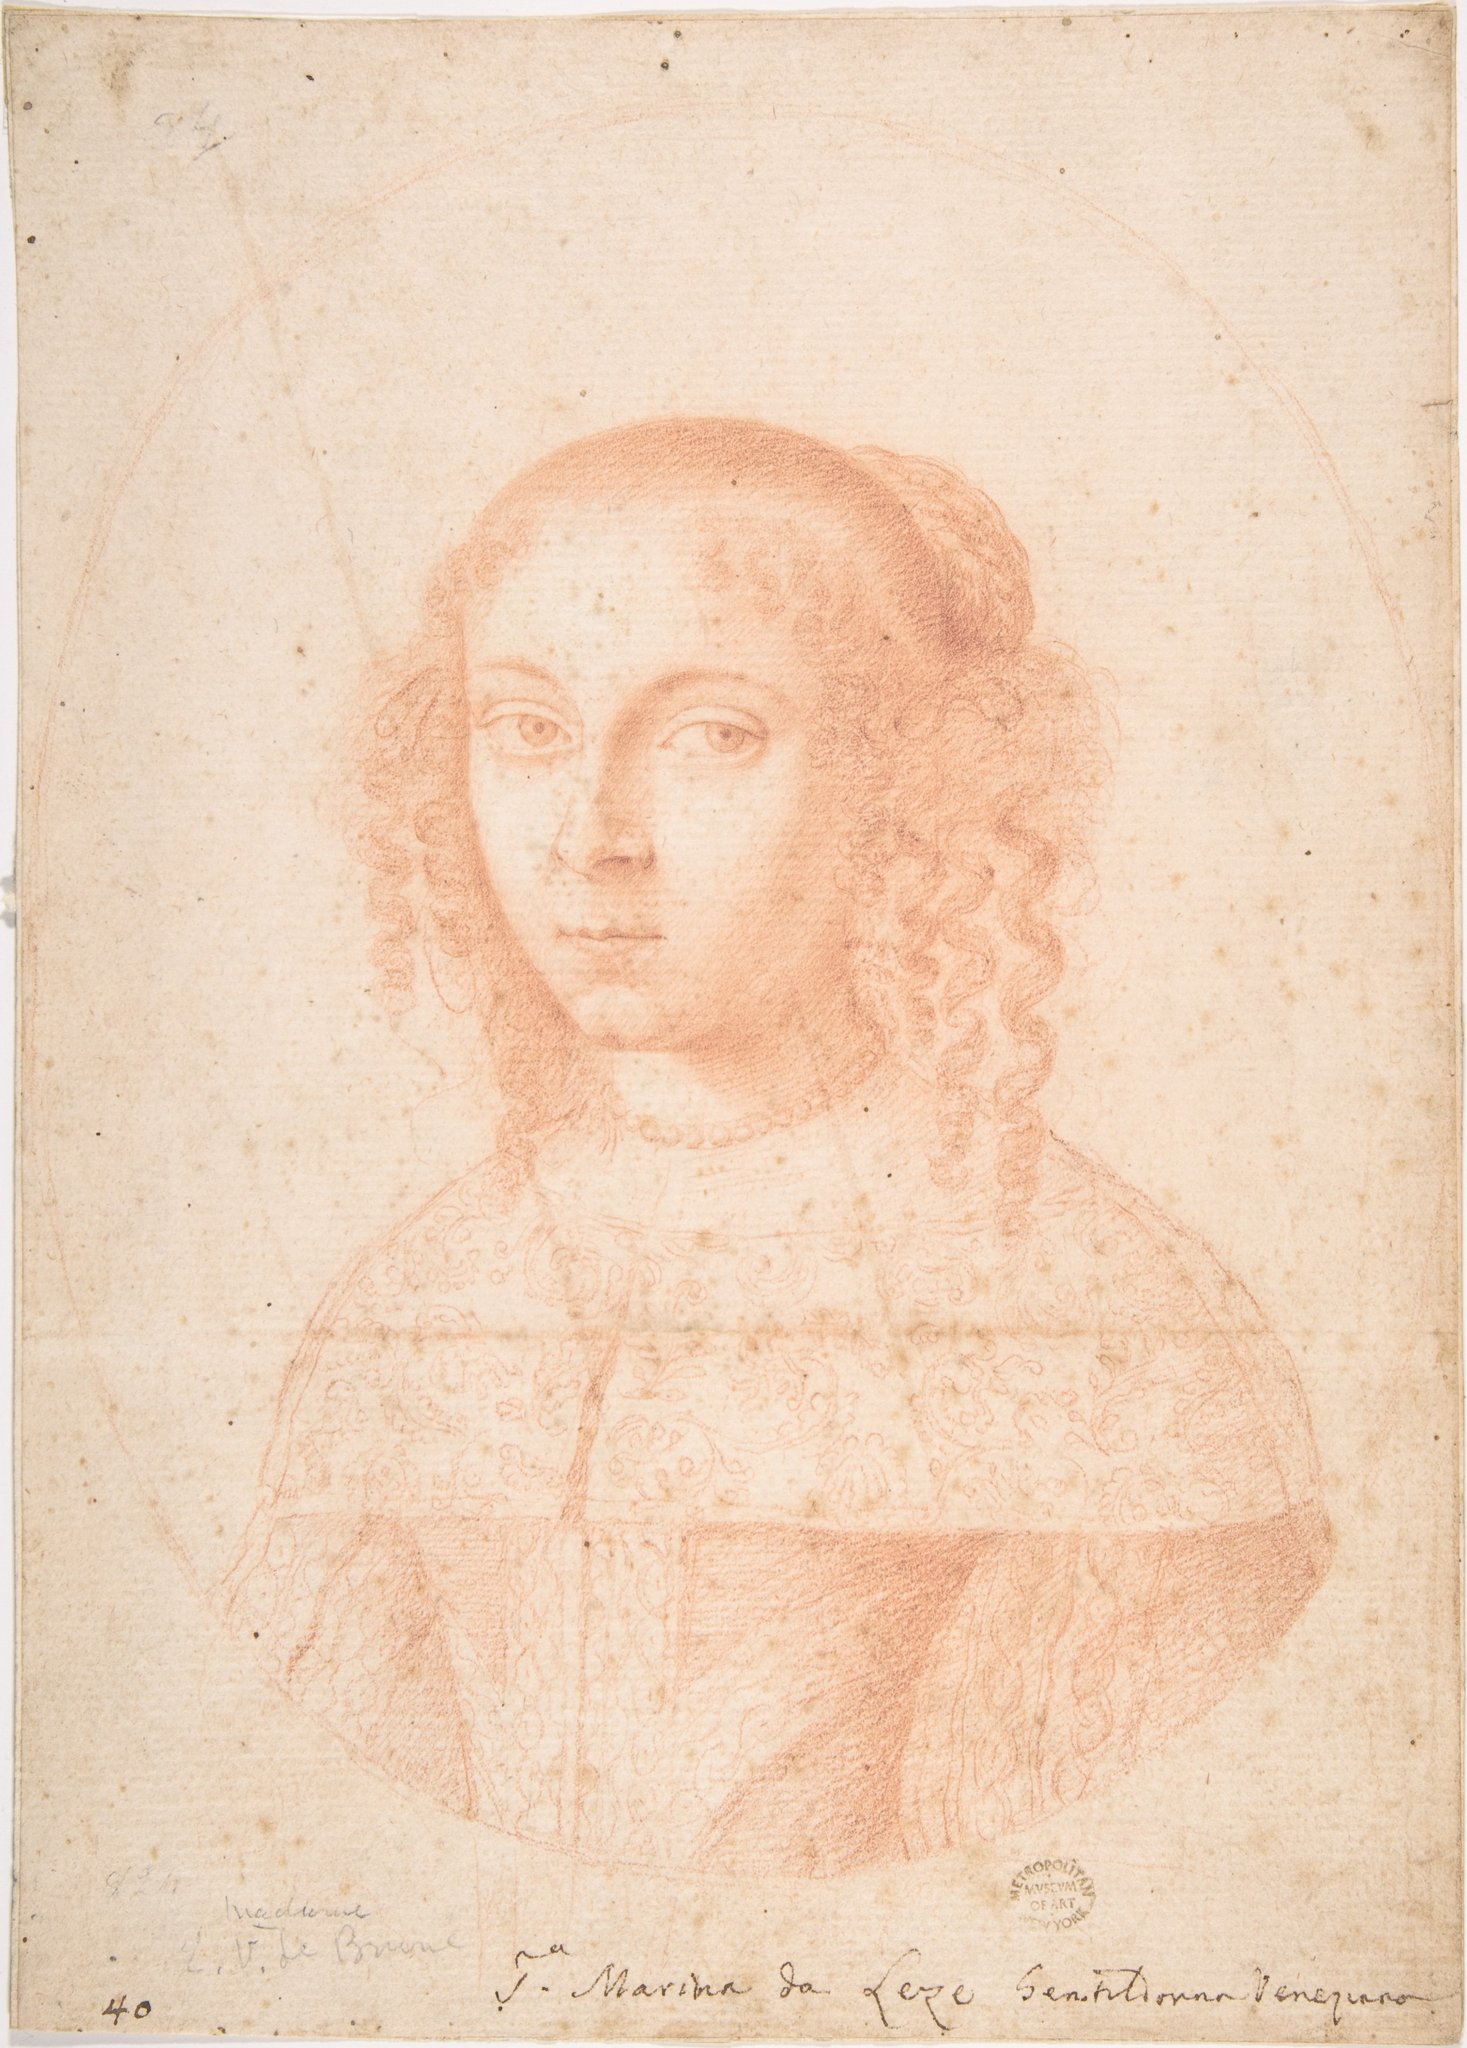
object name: drawing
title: Portrait of a Woman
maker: anonymous, italian, roman-bolognese, 17th century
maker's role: artist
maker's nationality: italian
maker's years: 1600-1700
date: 1601-1700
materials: chalk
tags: portraits,women